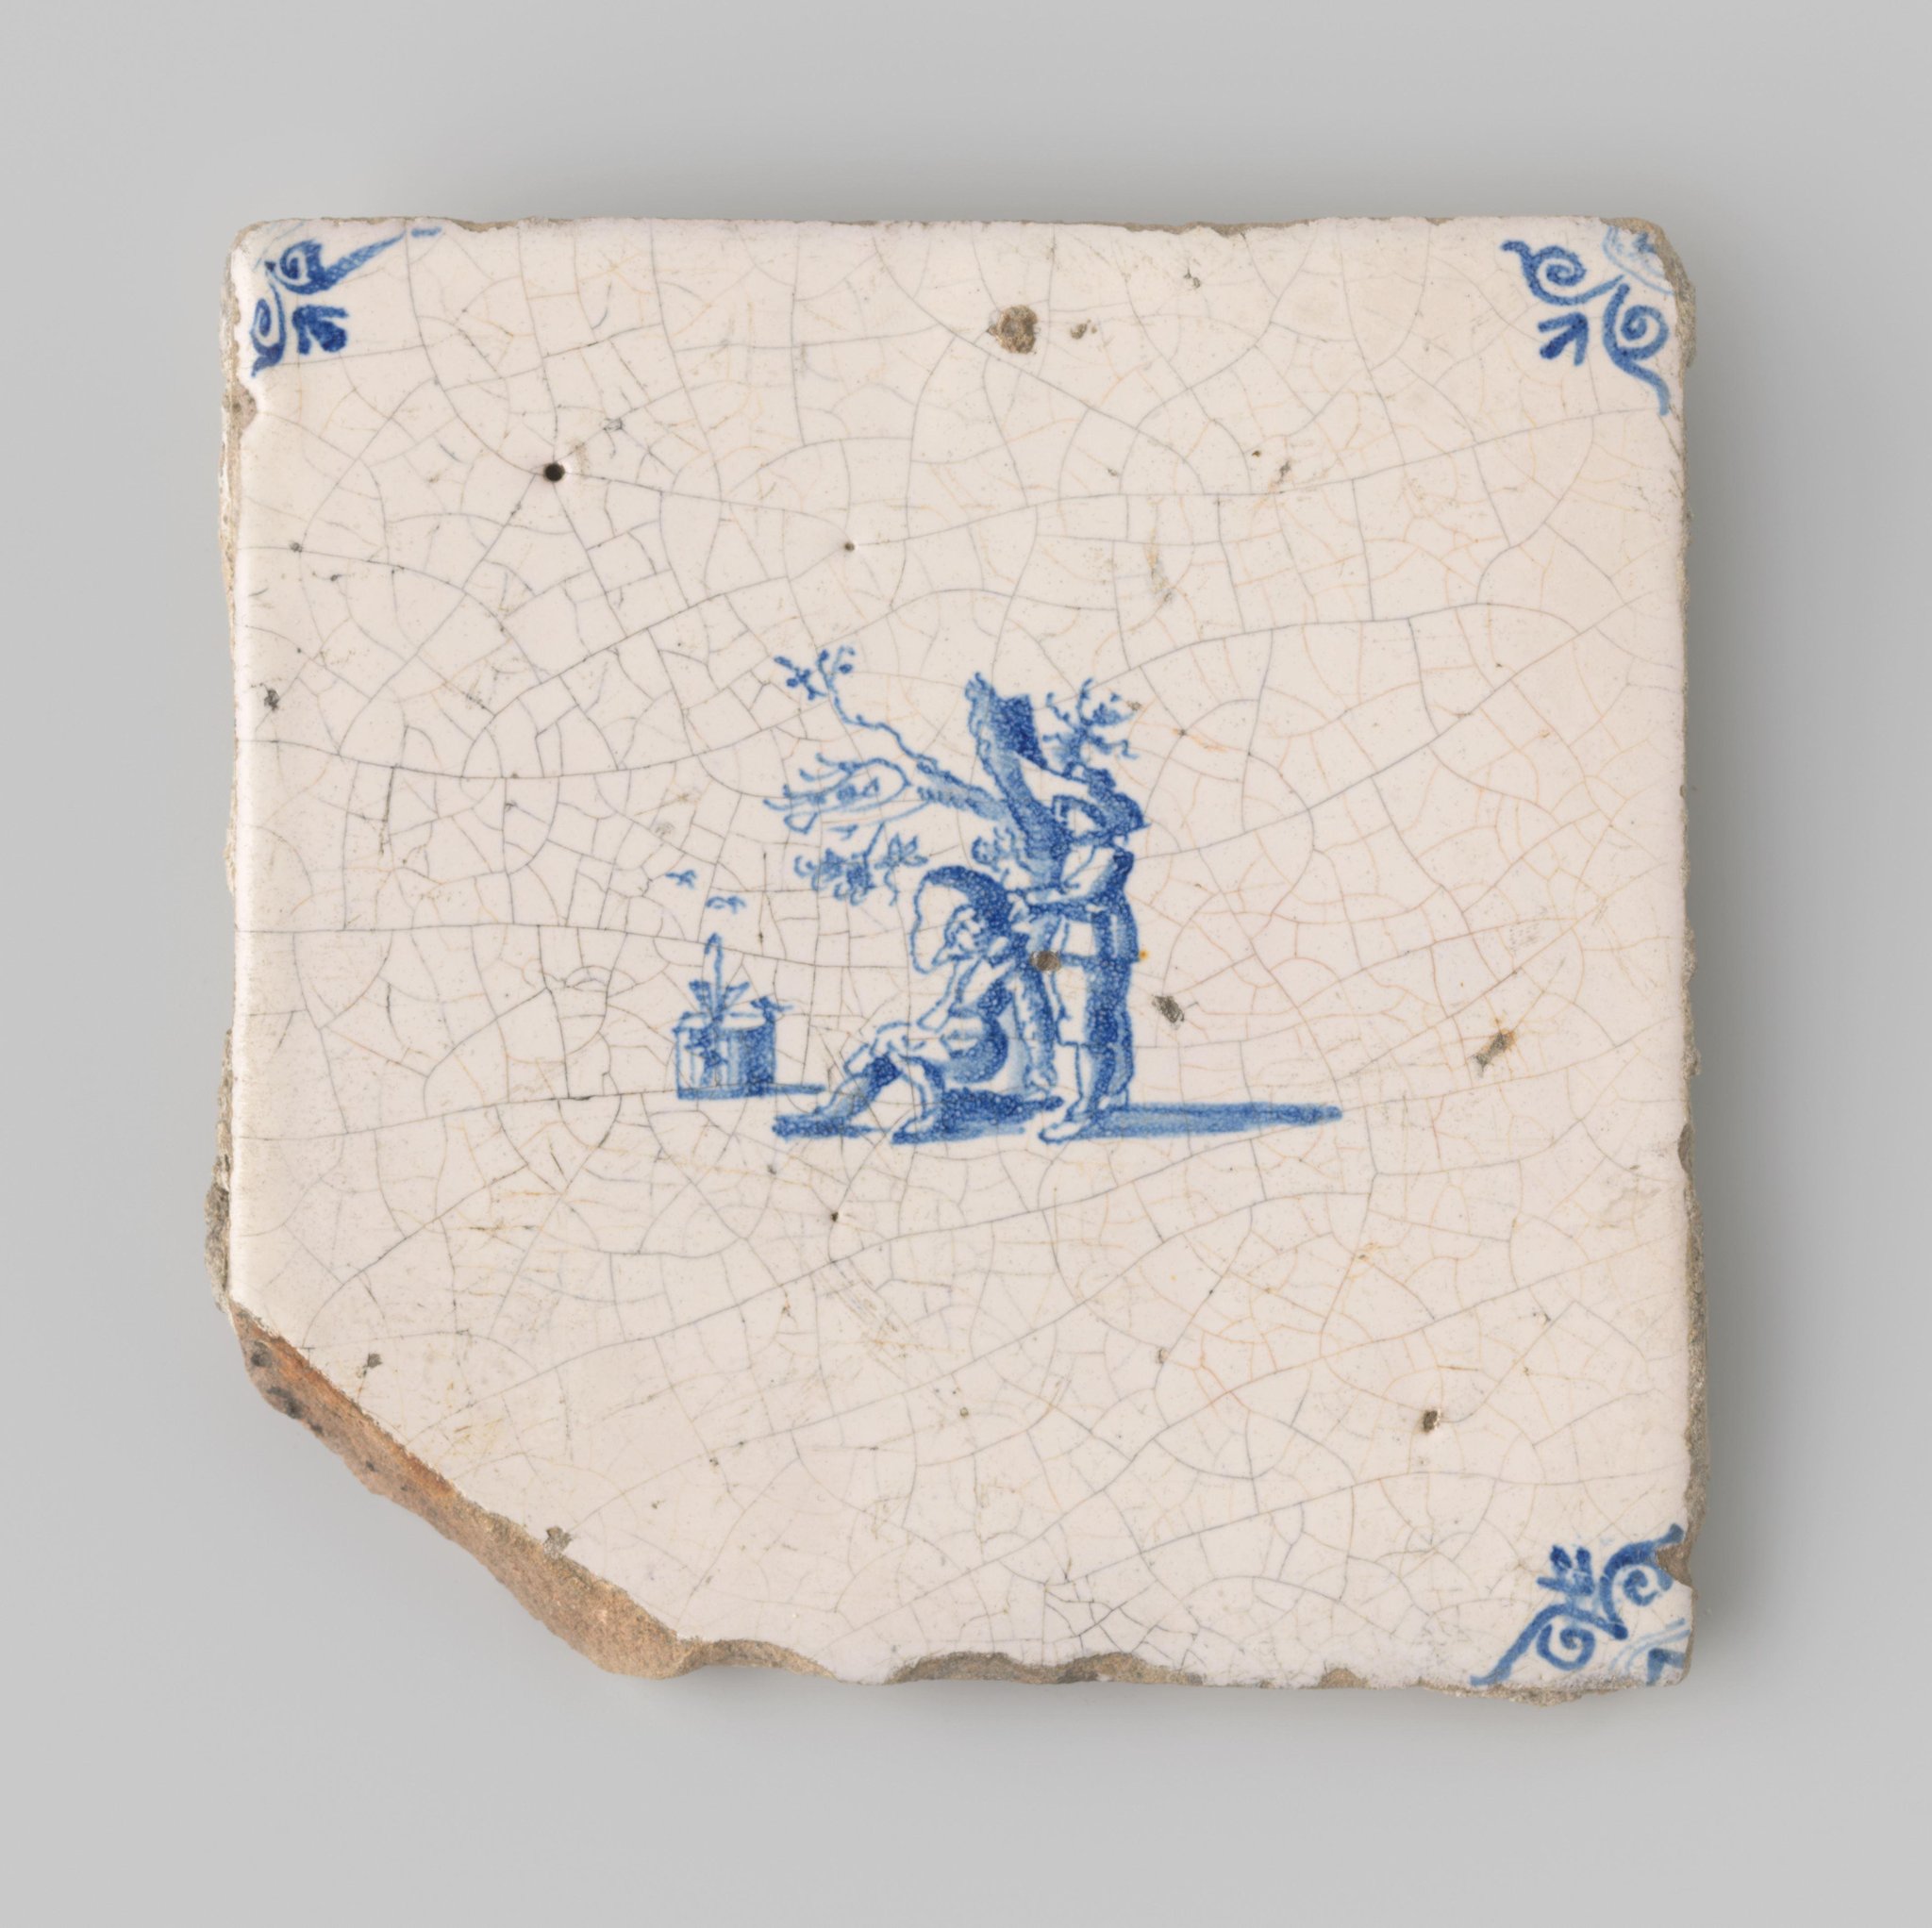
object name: tile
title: Tegel (beschadigd) voorzien van wit glazuur, waarop een tekening in blauw van twee personen bij een boom, en ornamenten op de hoeken van de tegel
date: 1500-1899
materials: earthenware, glaze